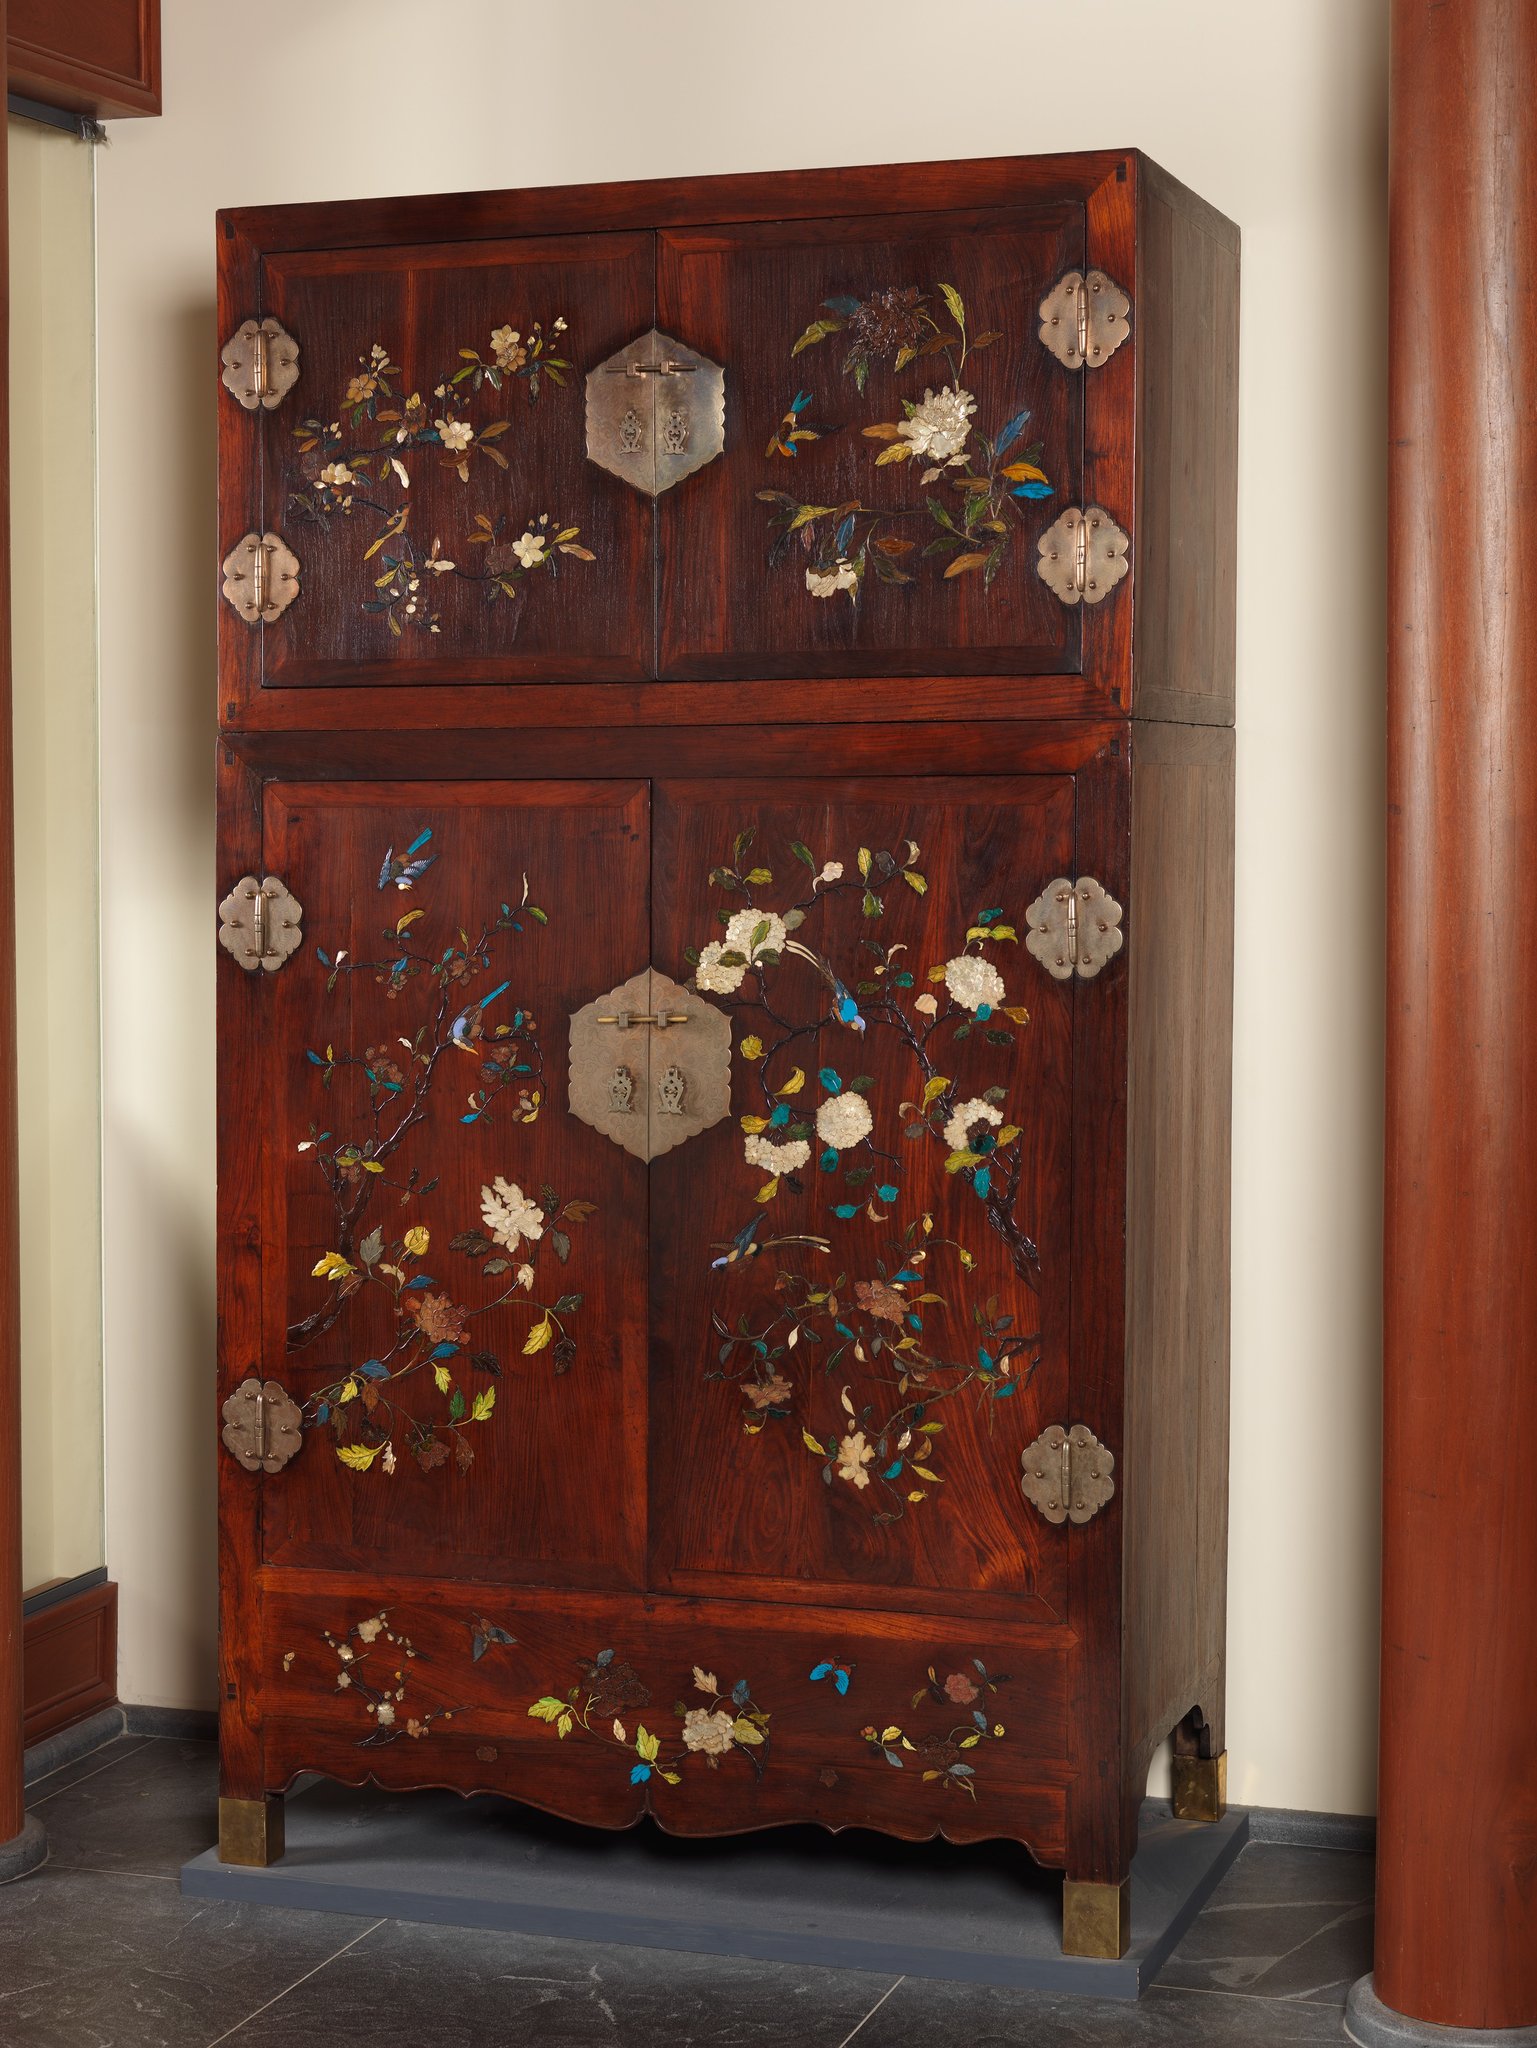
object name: wardrobe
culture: chinese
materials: amber, glass, ivory, mother of pearl, wood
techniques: inlay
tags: birds,flowers